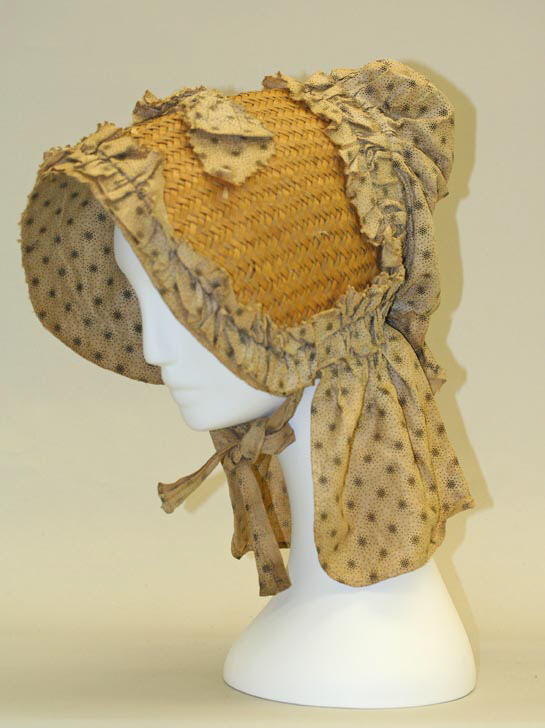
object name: bonnet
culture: american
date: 1838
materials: cotton